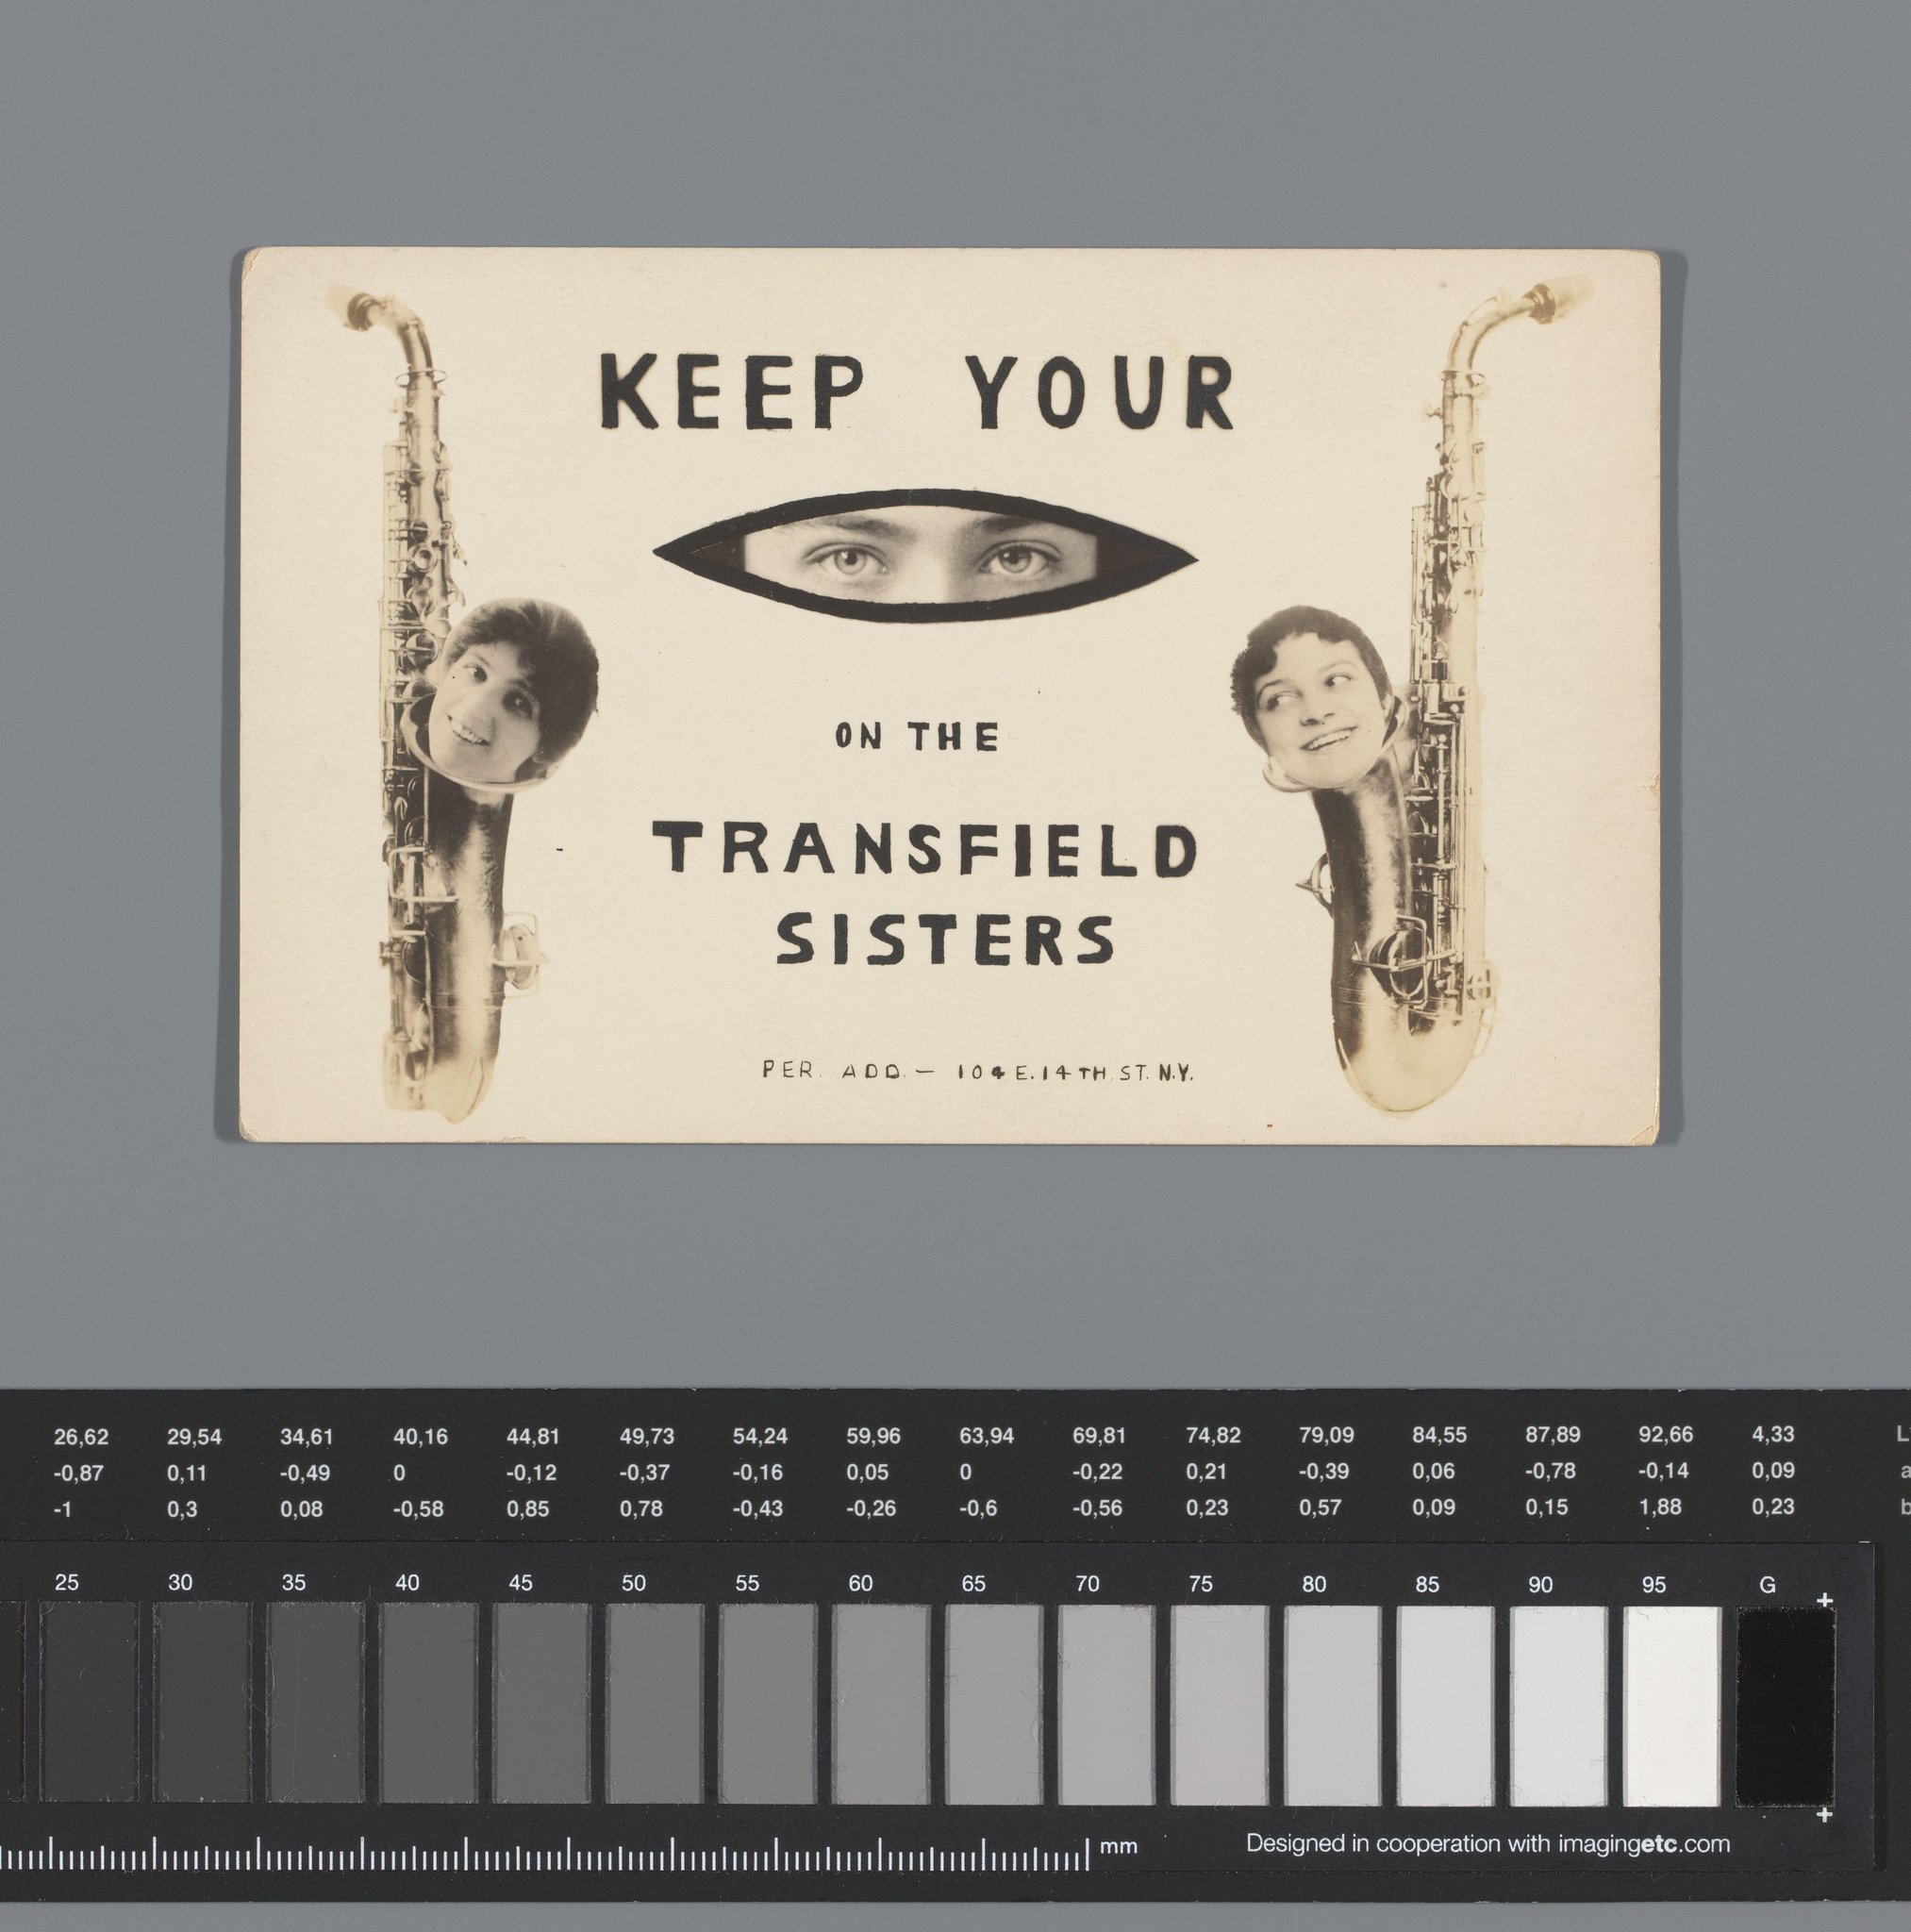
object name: ansichtkaart, prentbriefkaart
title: Reclame voor de Transfield Sisters (muzikanten) met twee saxofoons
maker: Anonymous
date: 1927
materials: photographic support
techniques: gelatin silver print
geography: united states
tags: saxophone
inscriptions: inscription: ‘KEEP YOUR / [eyes] / ON THE / TRANSFIELD SISTERS / PER ADD – 104 E. 14th. ST. N.Y.’